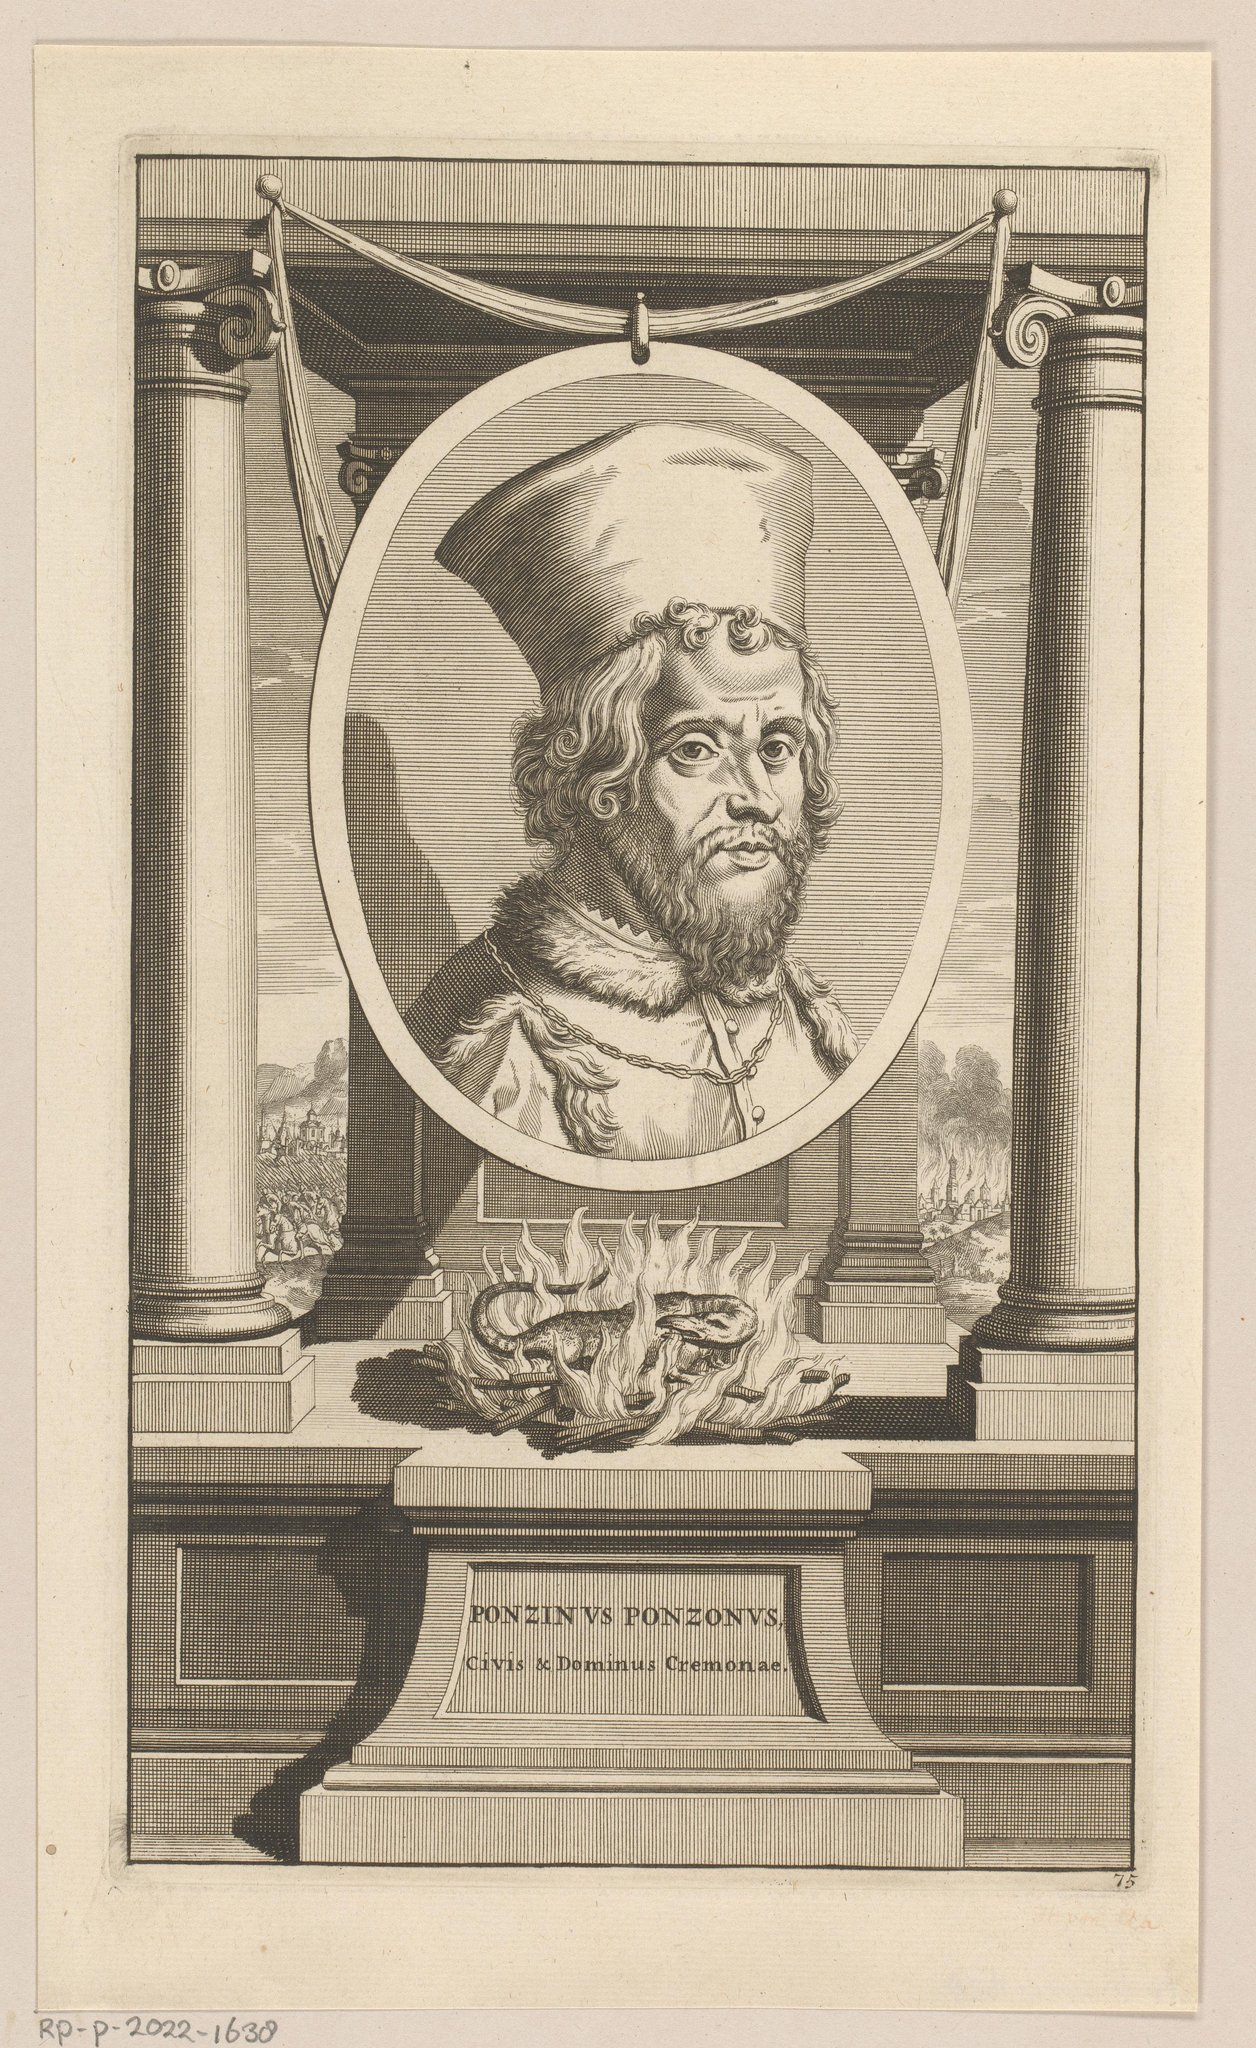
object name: print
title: Portretten van belangrijke leiders en geleerden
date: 1710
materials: paper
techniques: engraving, etching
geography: leiden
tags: historical persons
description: Prent uit de serie: Principum et illustrium quorundam virorum qui in Europa alibique terrarum quam fama quam eruditione celebres fuerunt, verae imagines. Leiden: Pieter van der Aa, [ca. 1710].